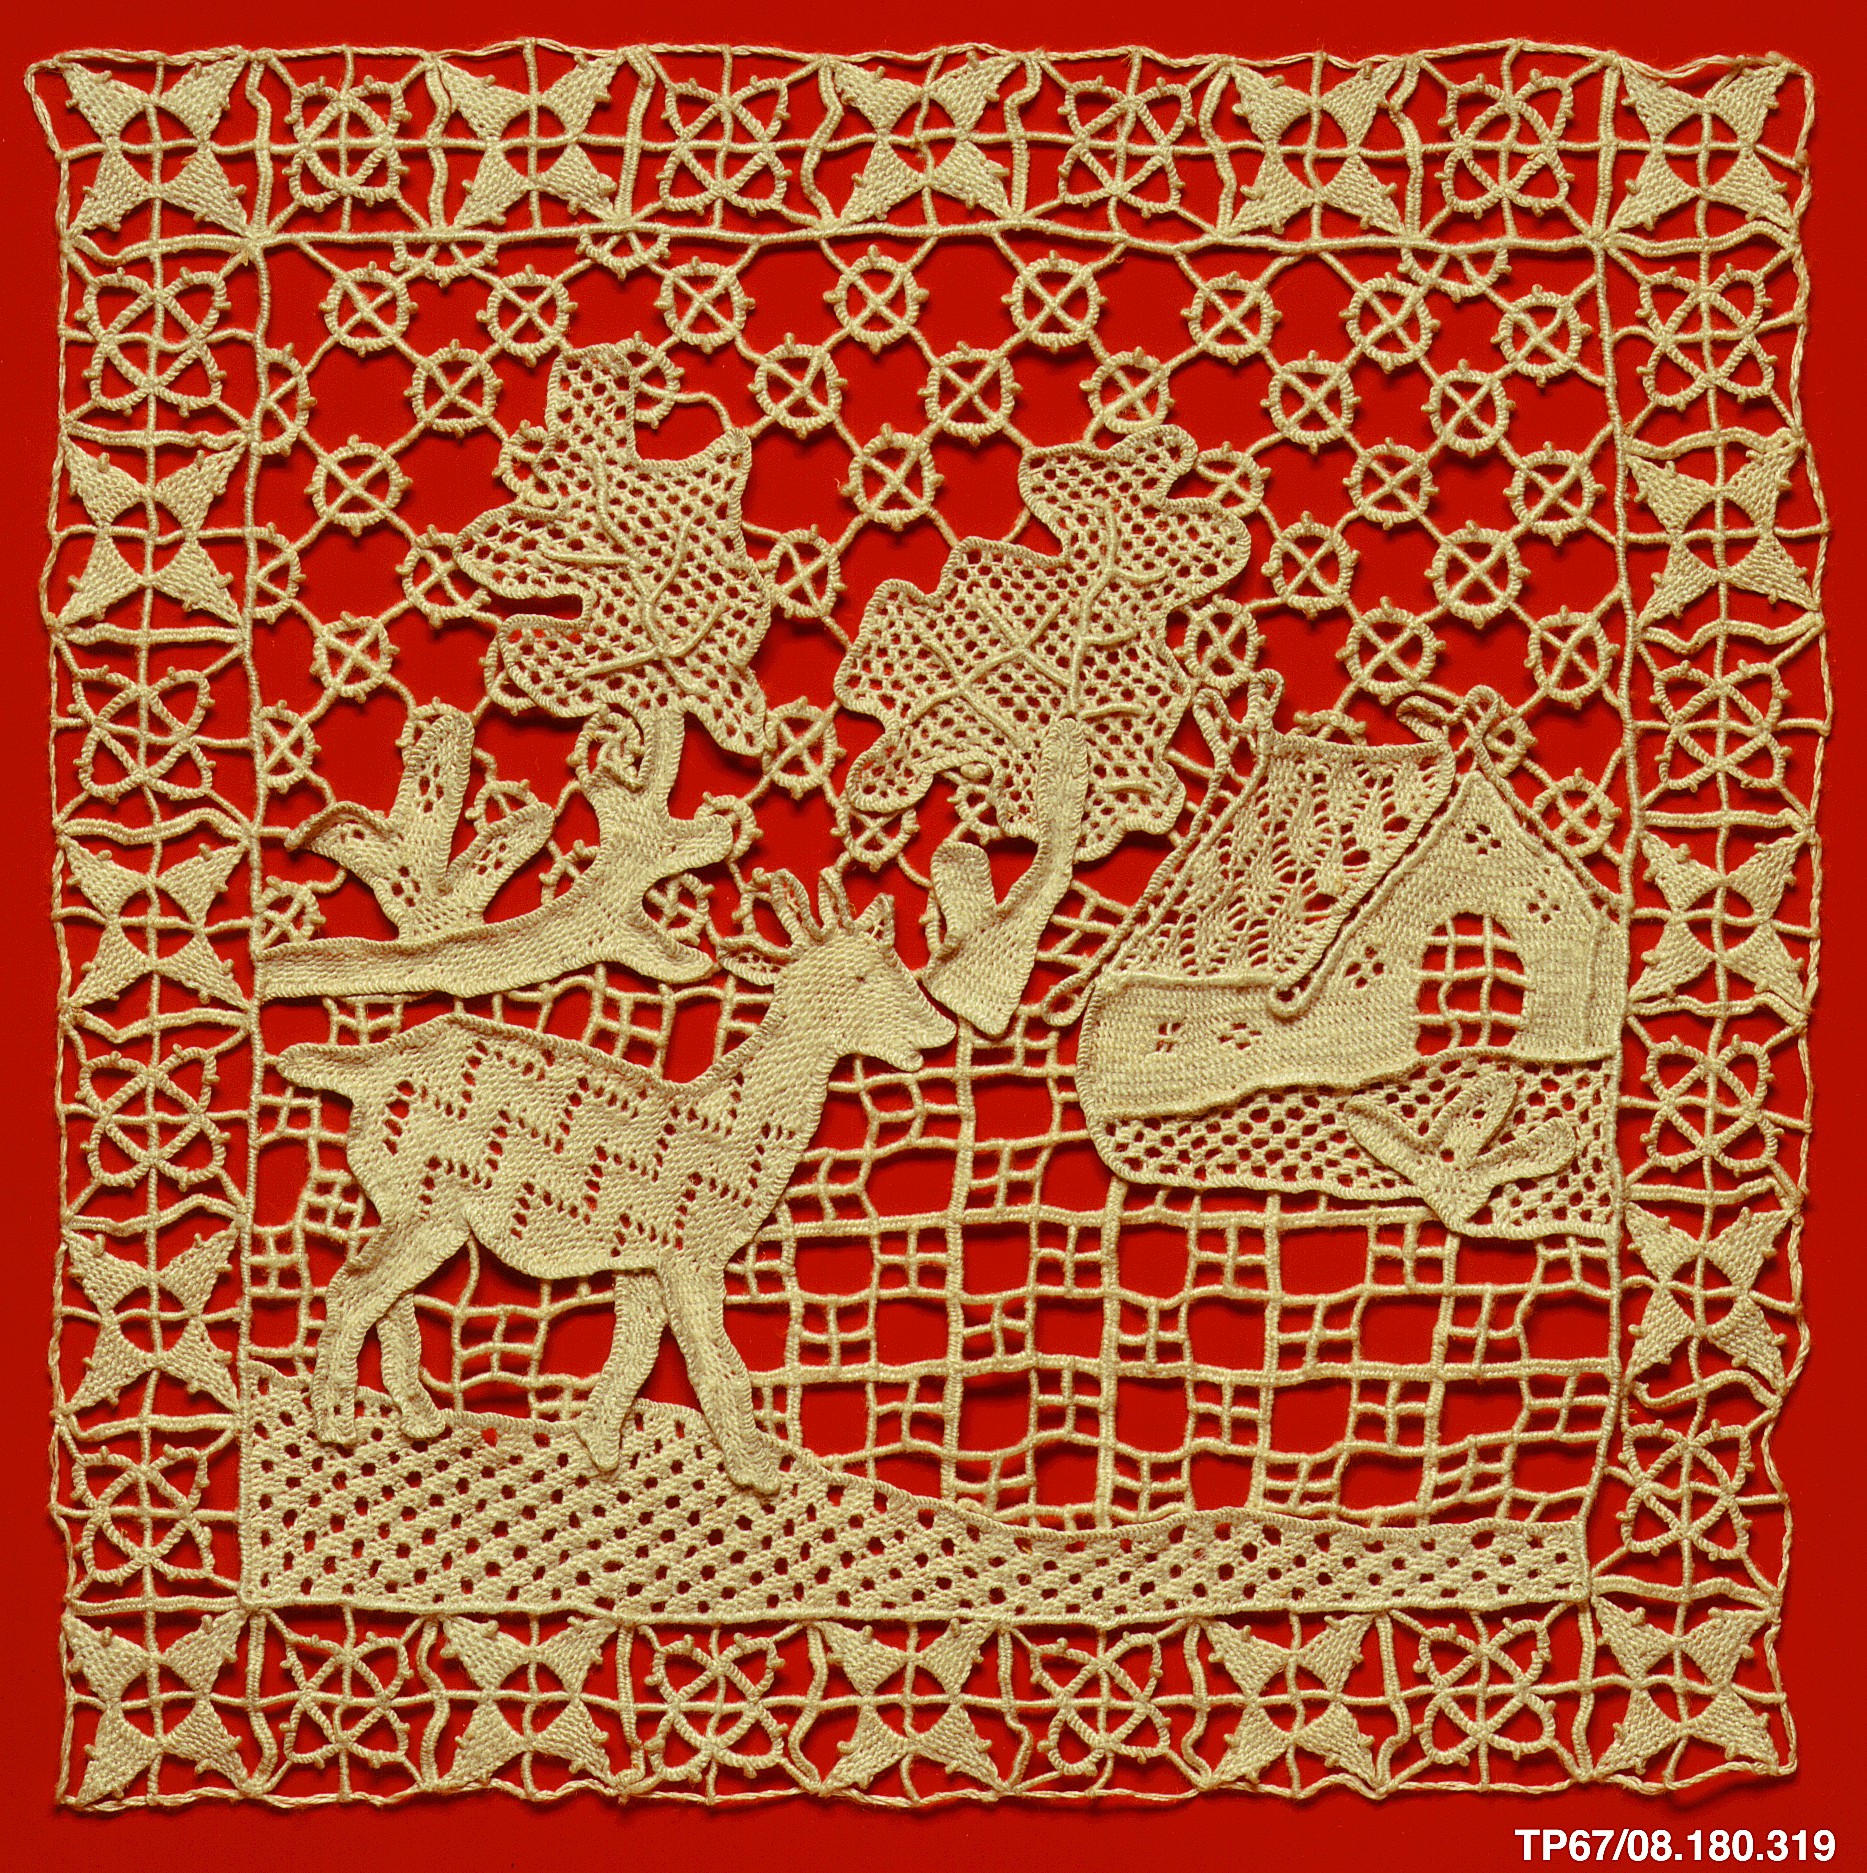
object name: square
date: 1801-1900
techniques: lace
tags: houses,deer,trees